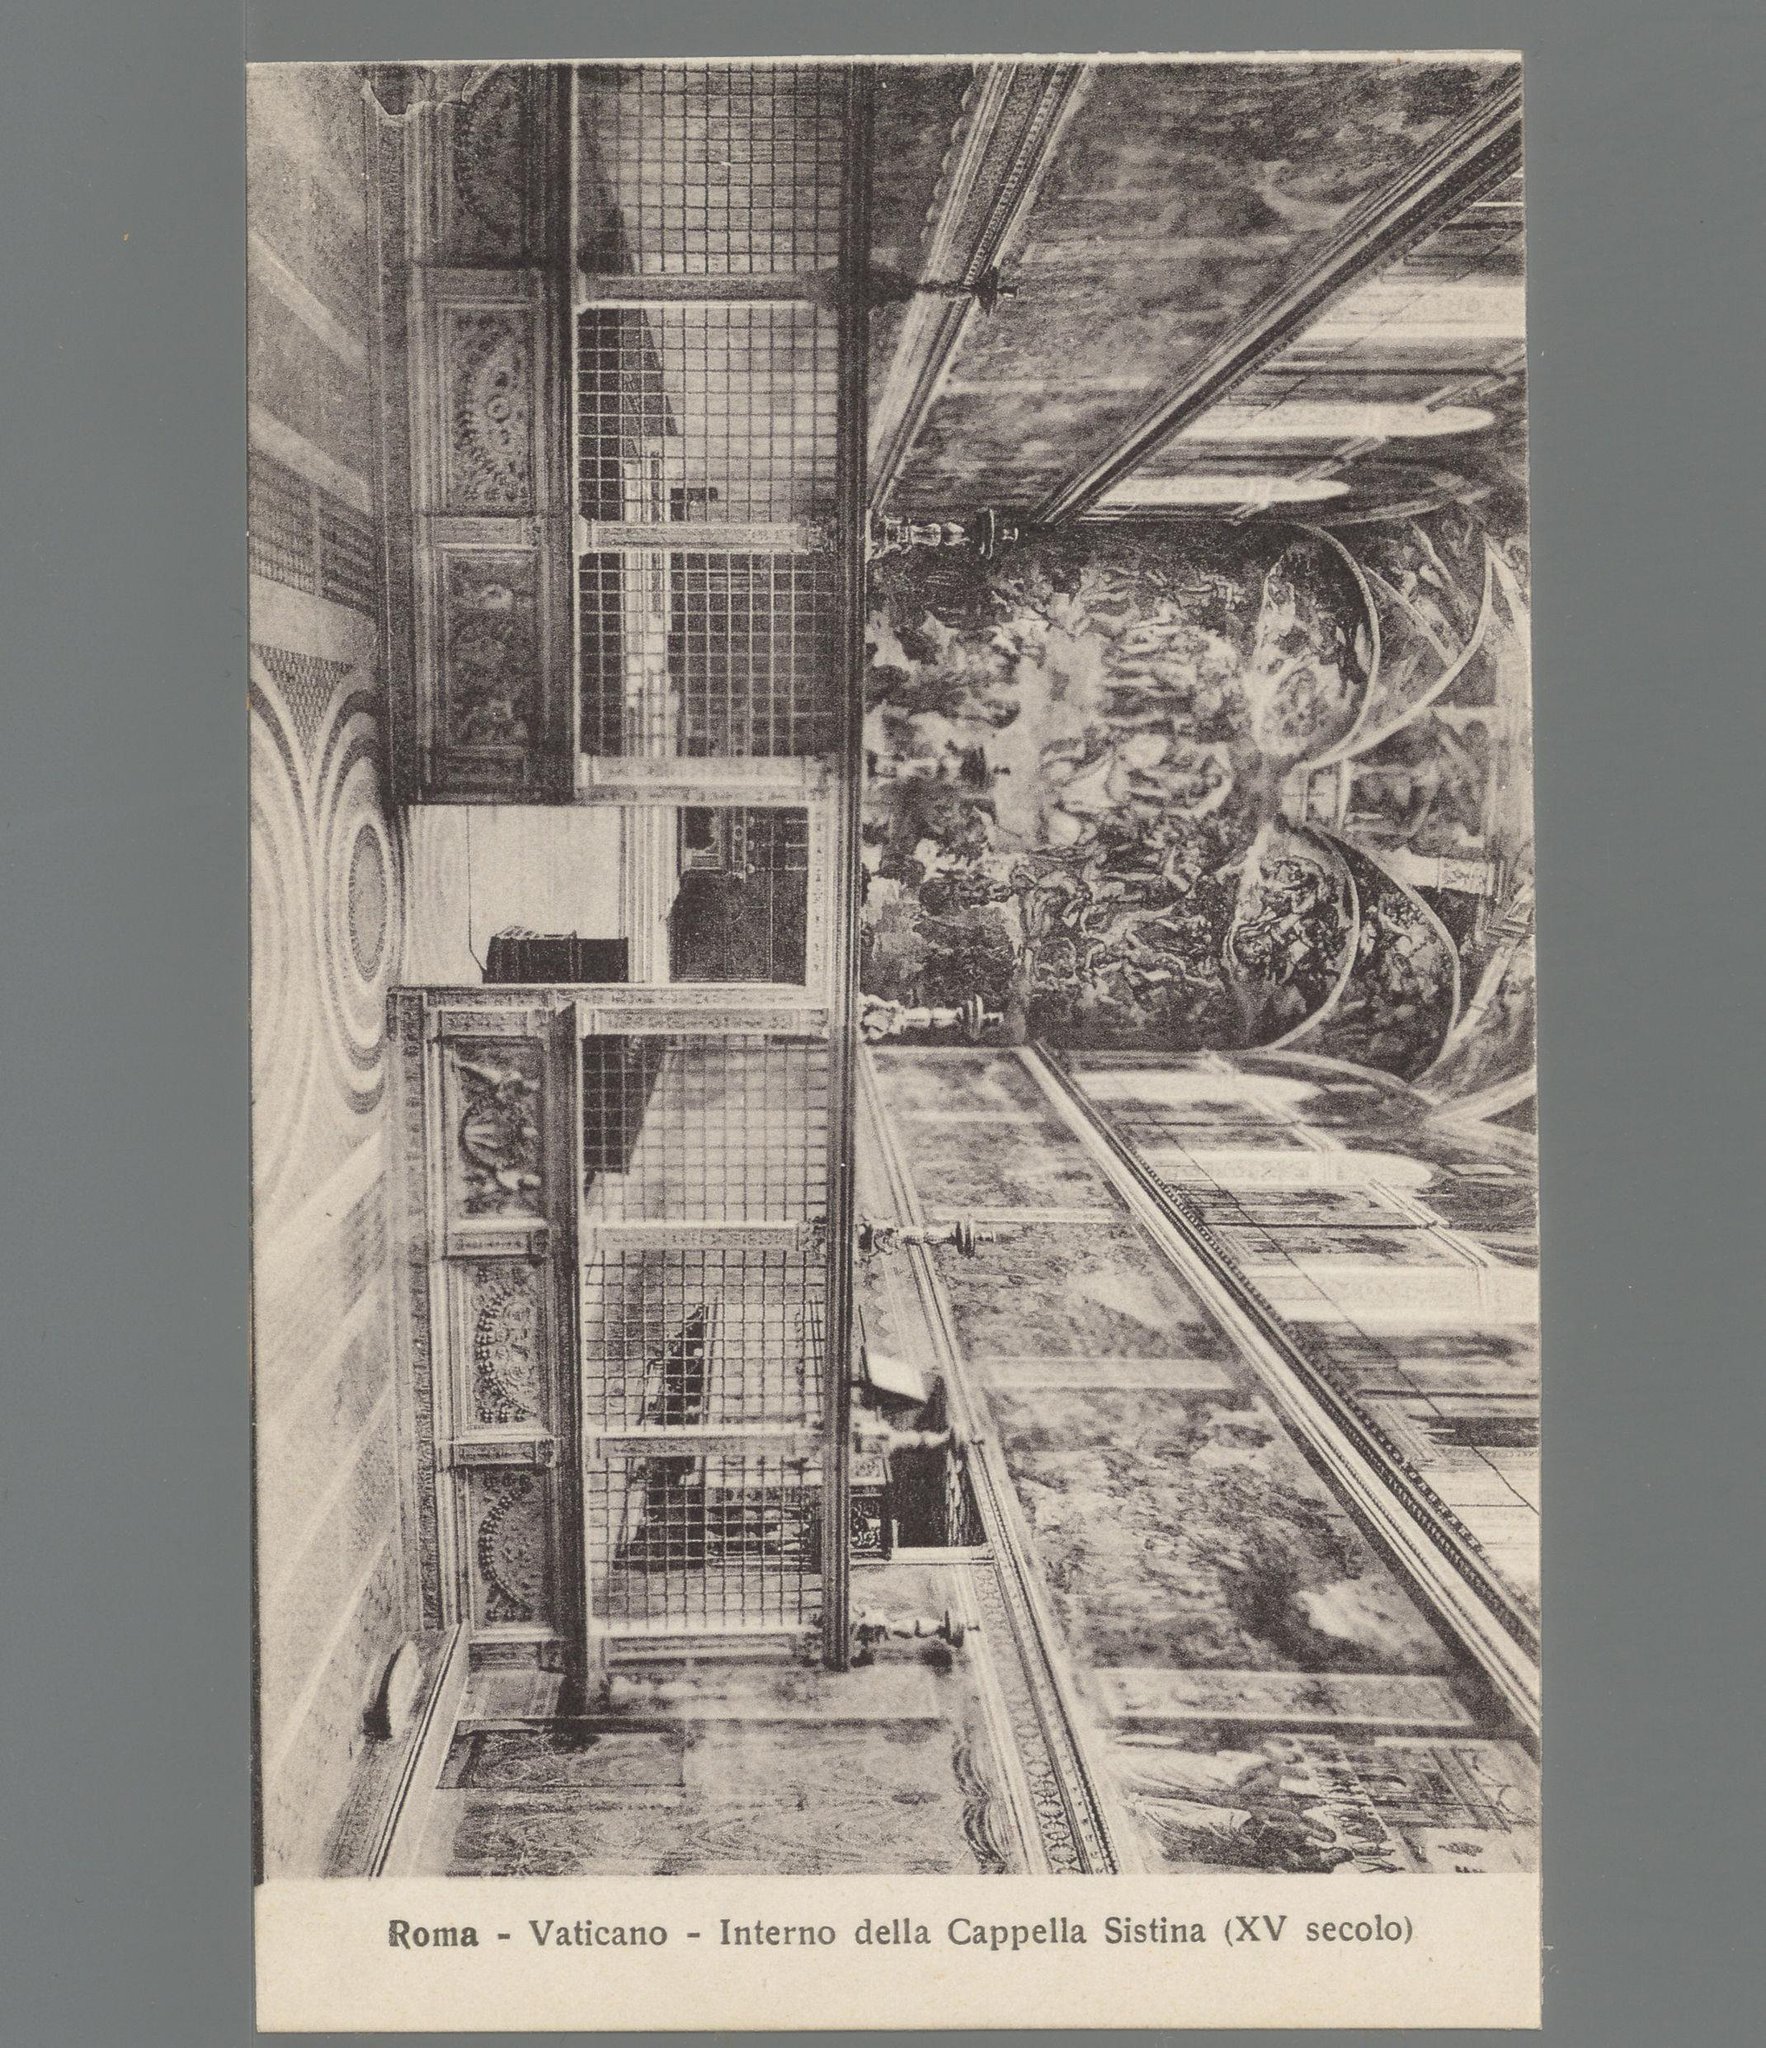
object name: photomechanical print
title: Roma. Vaticano. Interno della Cappella Sistina (XV secolo)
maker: Anonymous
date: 1910-1930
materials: cardboard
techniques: photograph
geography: rome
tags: palace - aa - civic architecture: inside, chapel (interior of the house)